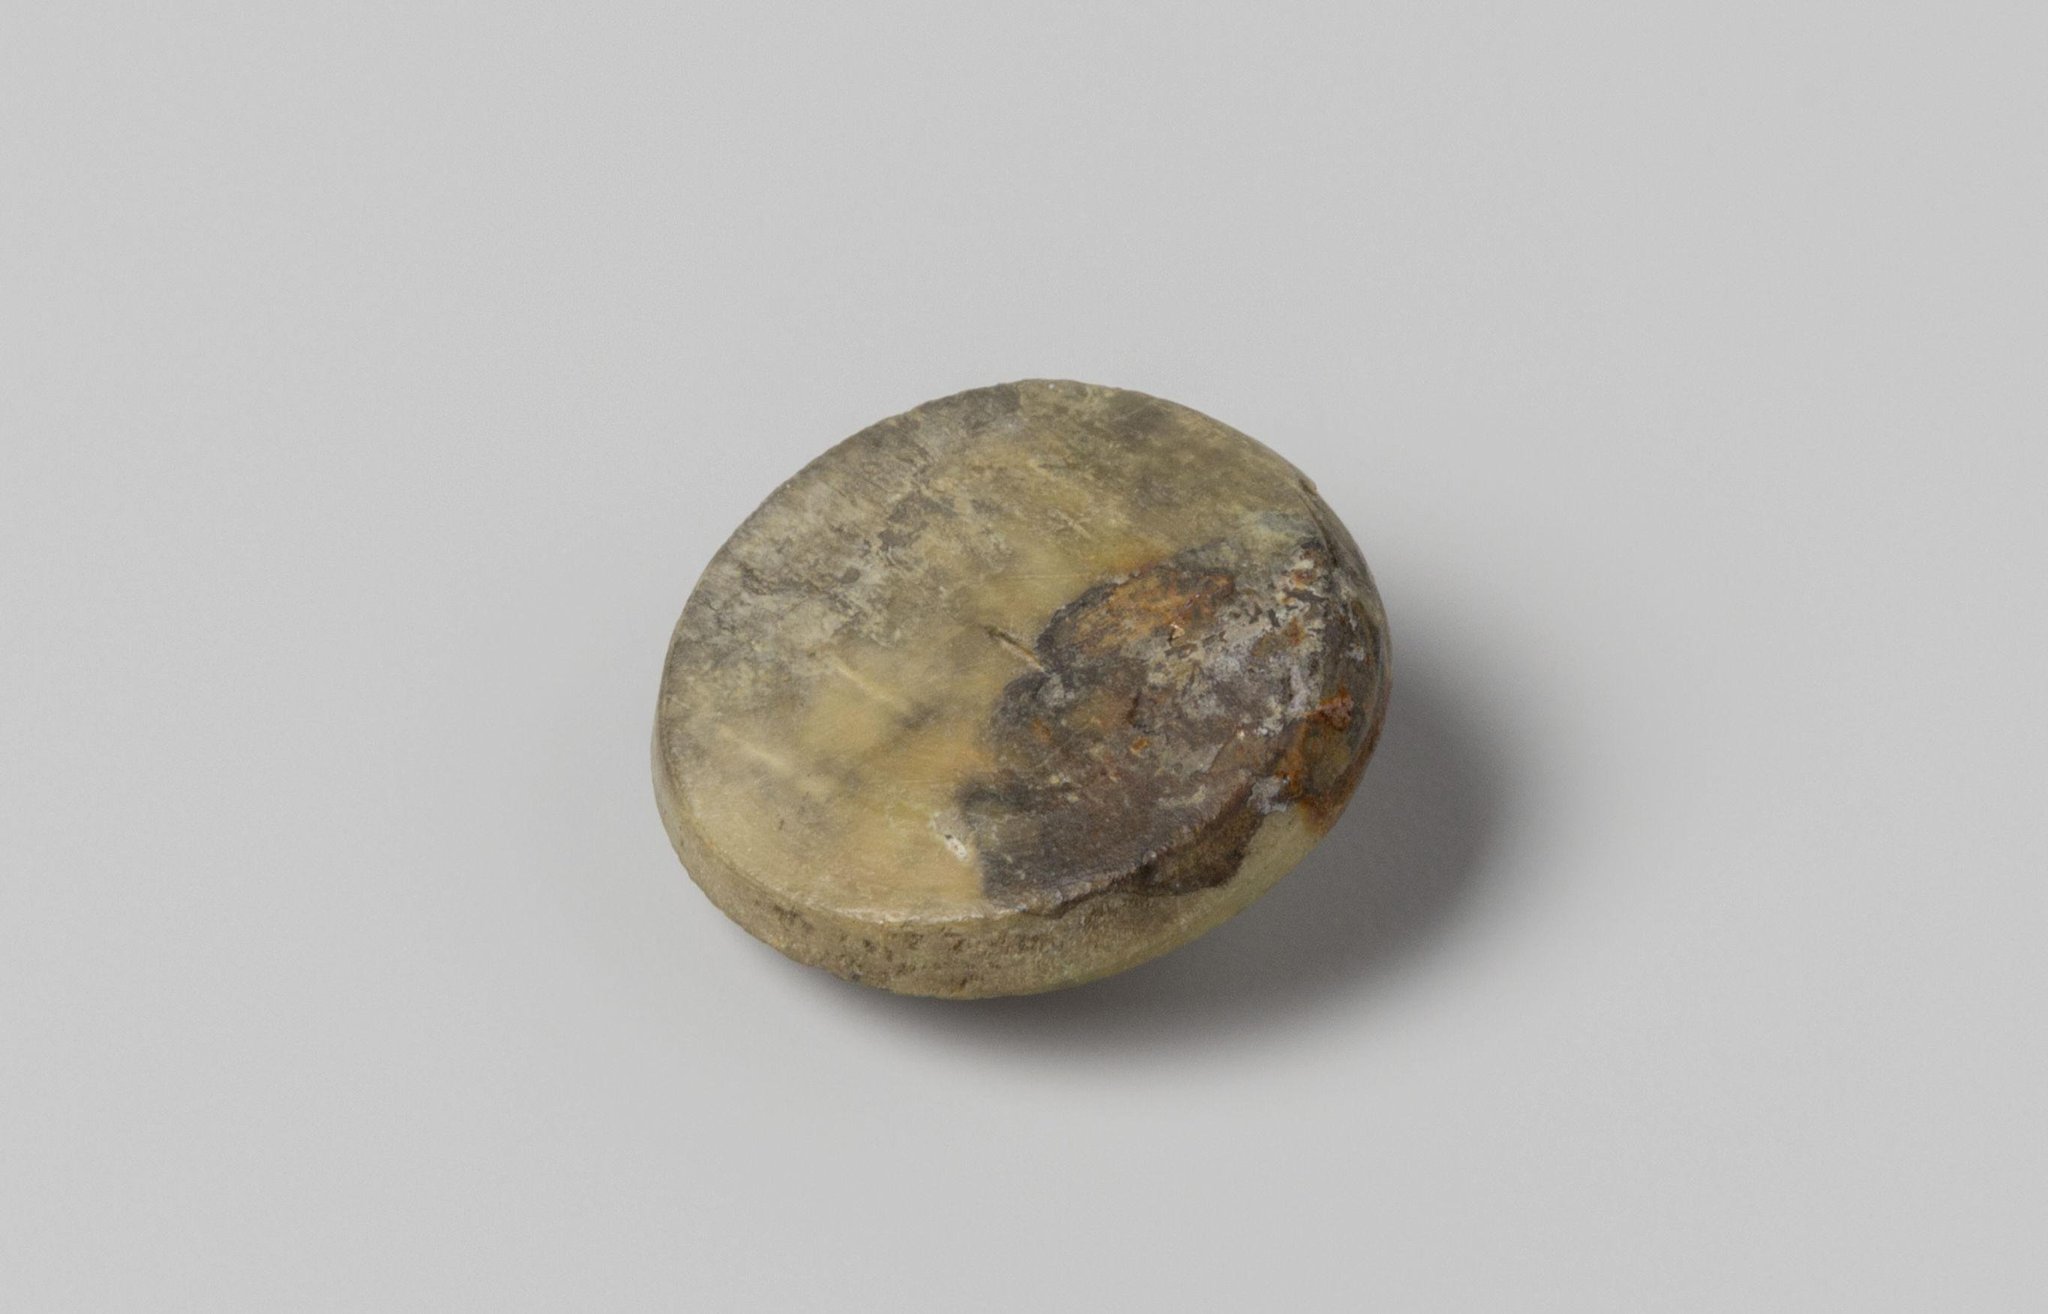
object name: button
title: Knoop uit het wrak van de Oost-Indiëvaarder Hollandia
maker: Anonymous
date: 1700-1743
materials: bone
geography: netherlands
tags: verenigde oostindische compagnie, hollandia (schip), annet